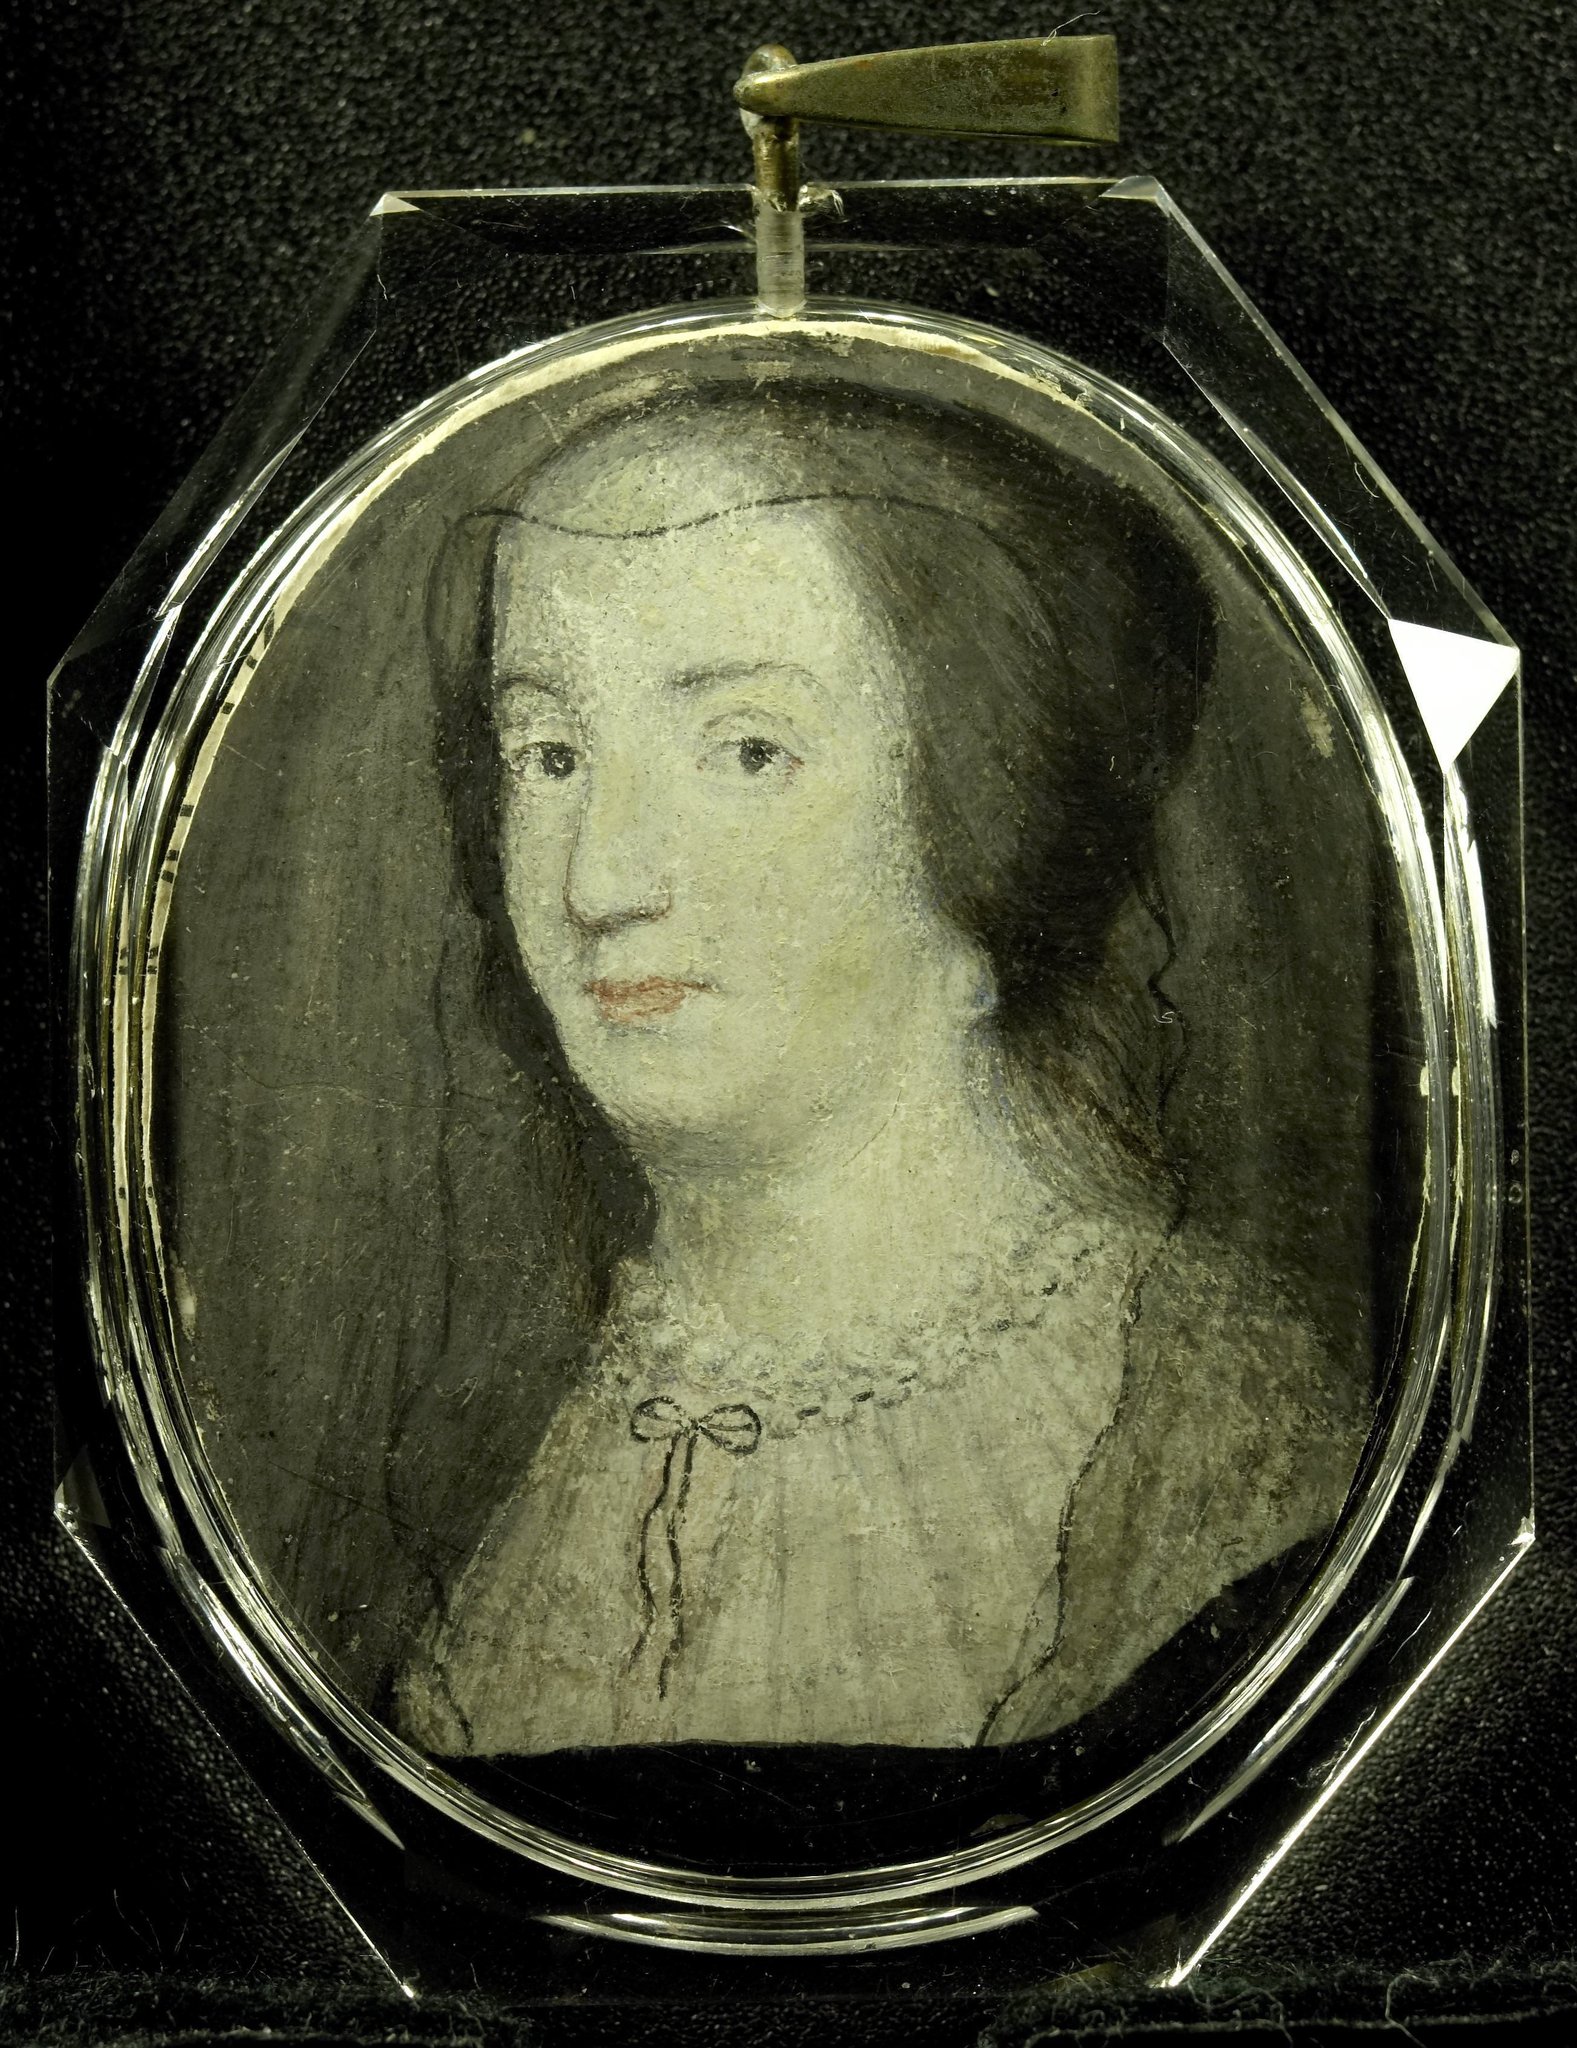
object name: painting, miniature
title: Amalia van Solms (1602-75). Weduwe van prins Frederik Hendrik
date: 1647-1650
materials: cardboard, crystal, metal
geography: netherlands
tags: the hague, amalia of solms-braunfels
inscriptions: inscription: ‘Amelie Orange’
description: Portret van Amalia van Solms (1602-75). Weduwe van prins Frederik Hendrik. Buste naar links, aanziend. Op de achterzijde een doodshoofd met gekruiste beenderen. Naar het origineel door Willem van Honthorst bestemd voor de kopel van de Oranjezaal, thans in de Staatliche Gemäldegalerie te Berlijn. Onderdeel van de collectie portretminiaturen.